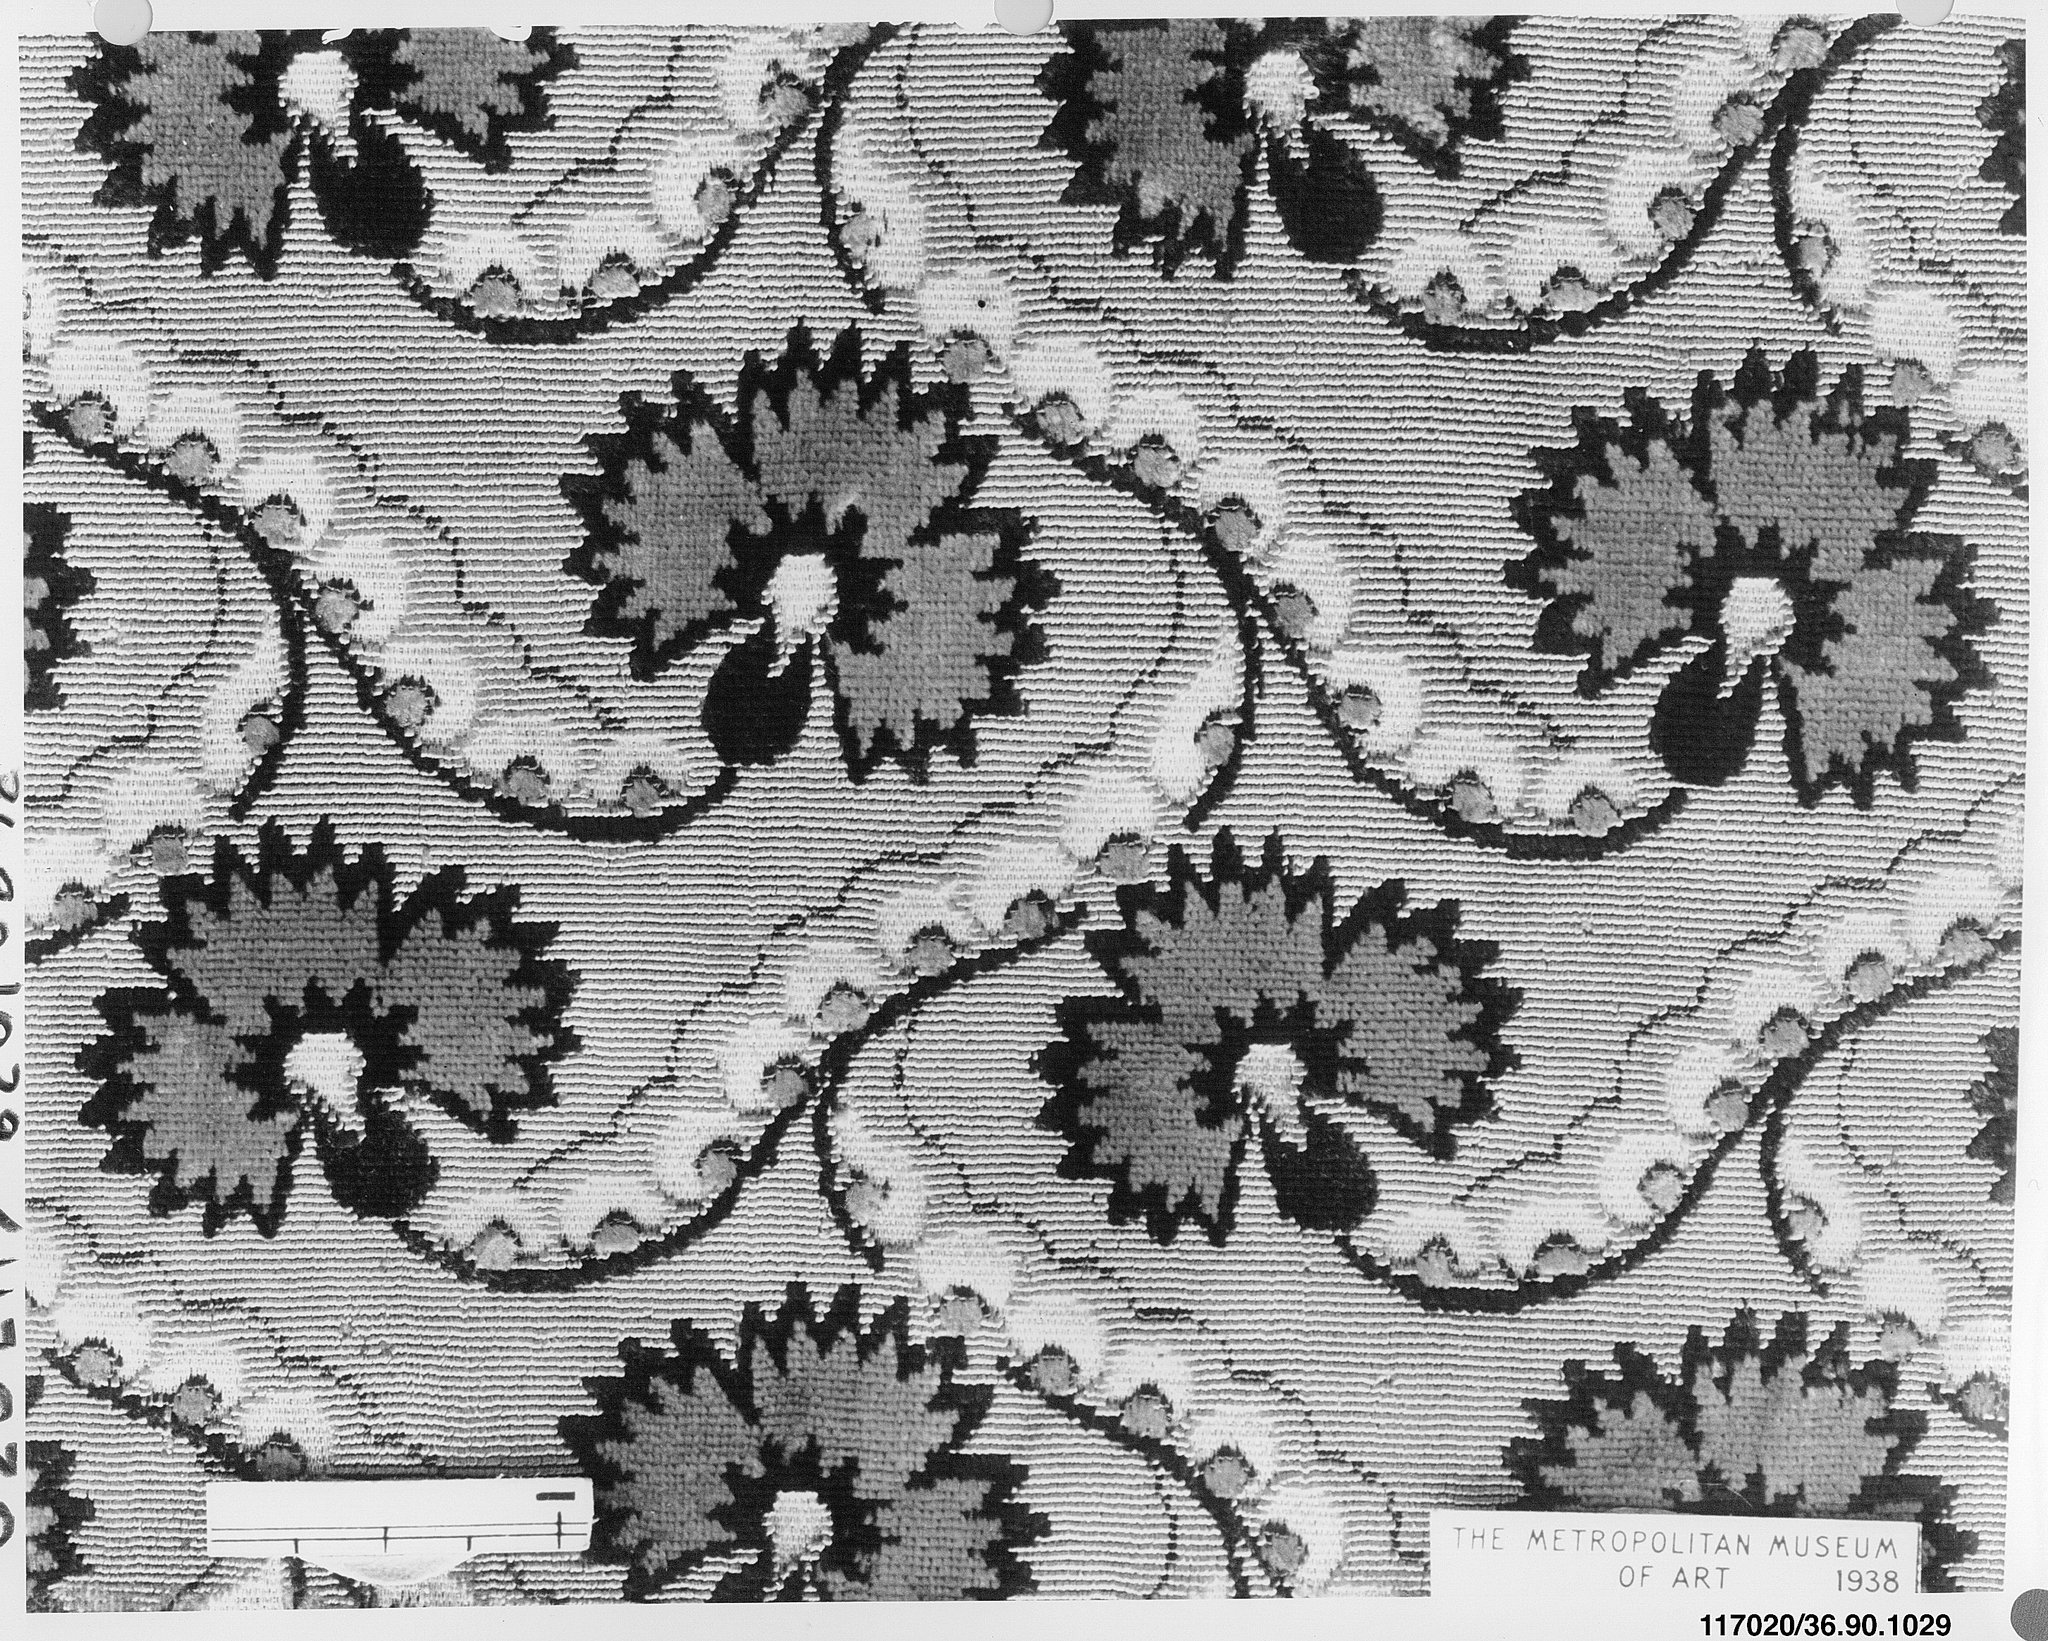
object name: piece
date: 1701-1800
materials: silk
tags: flowers